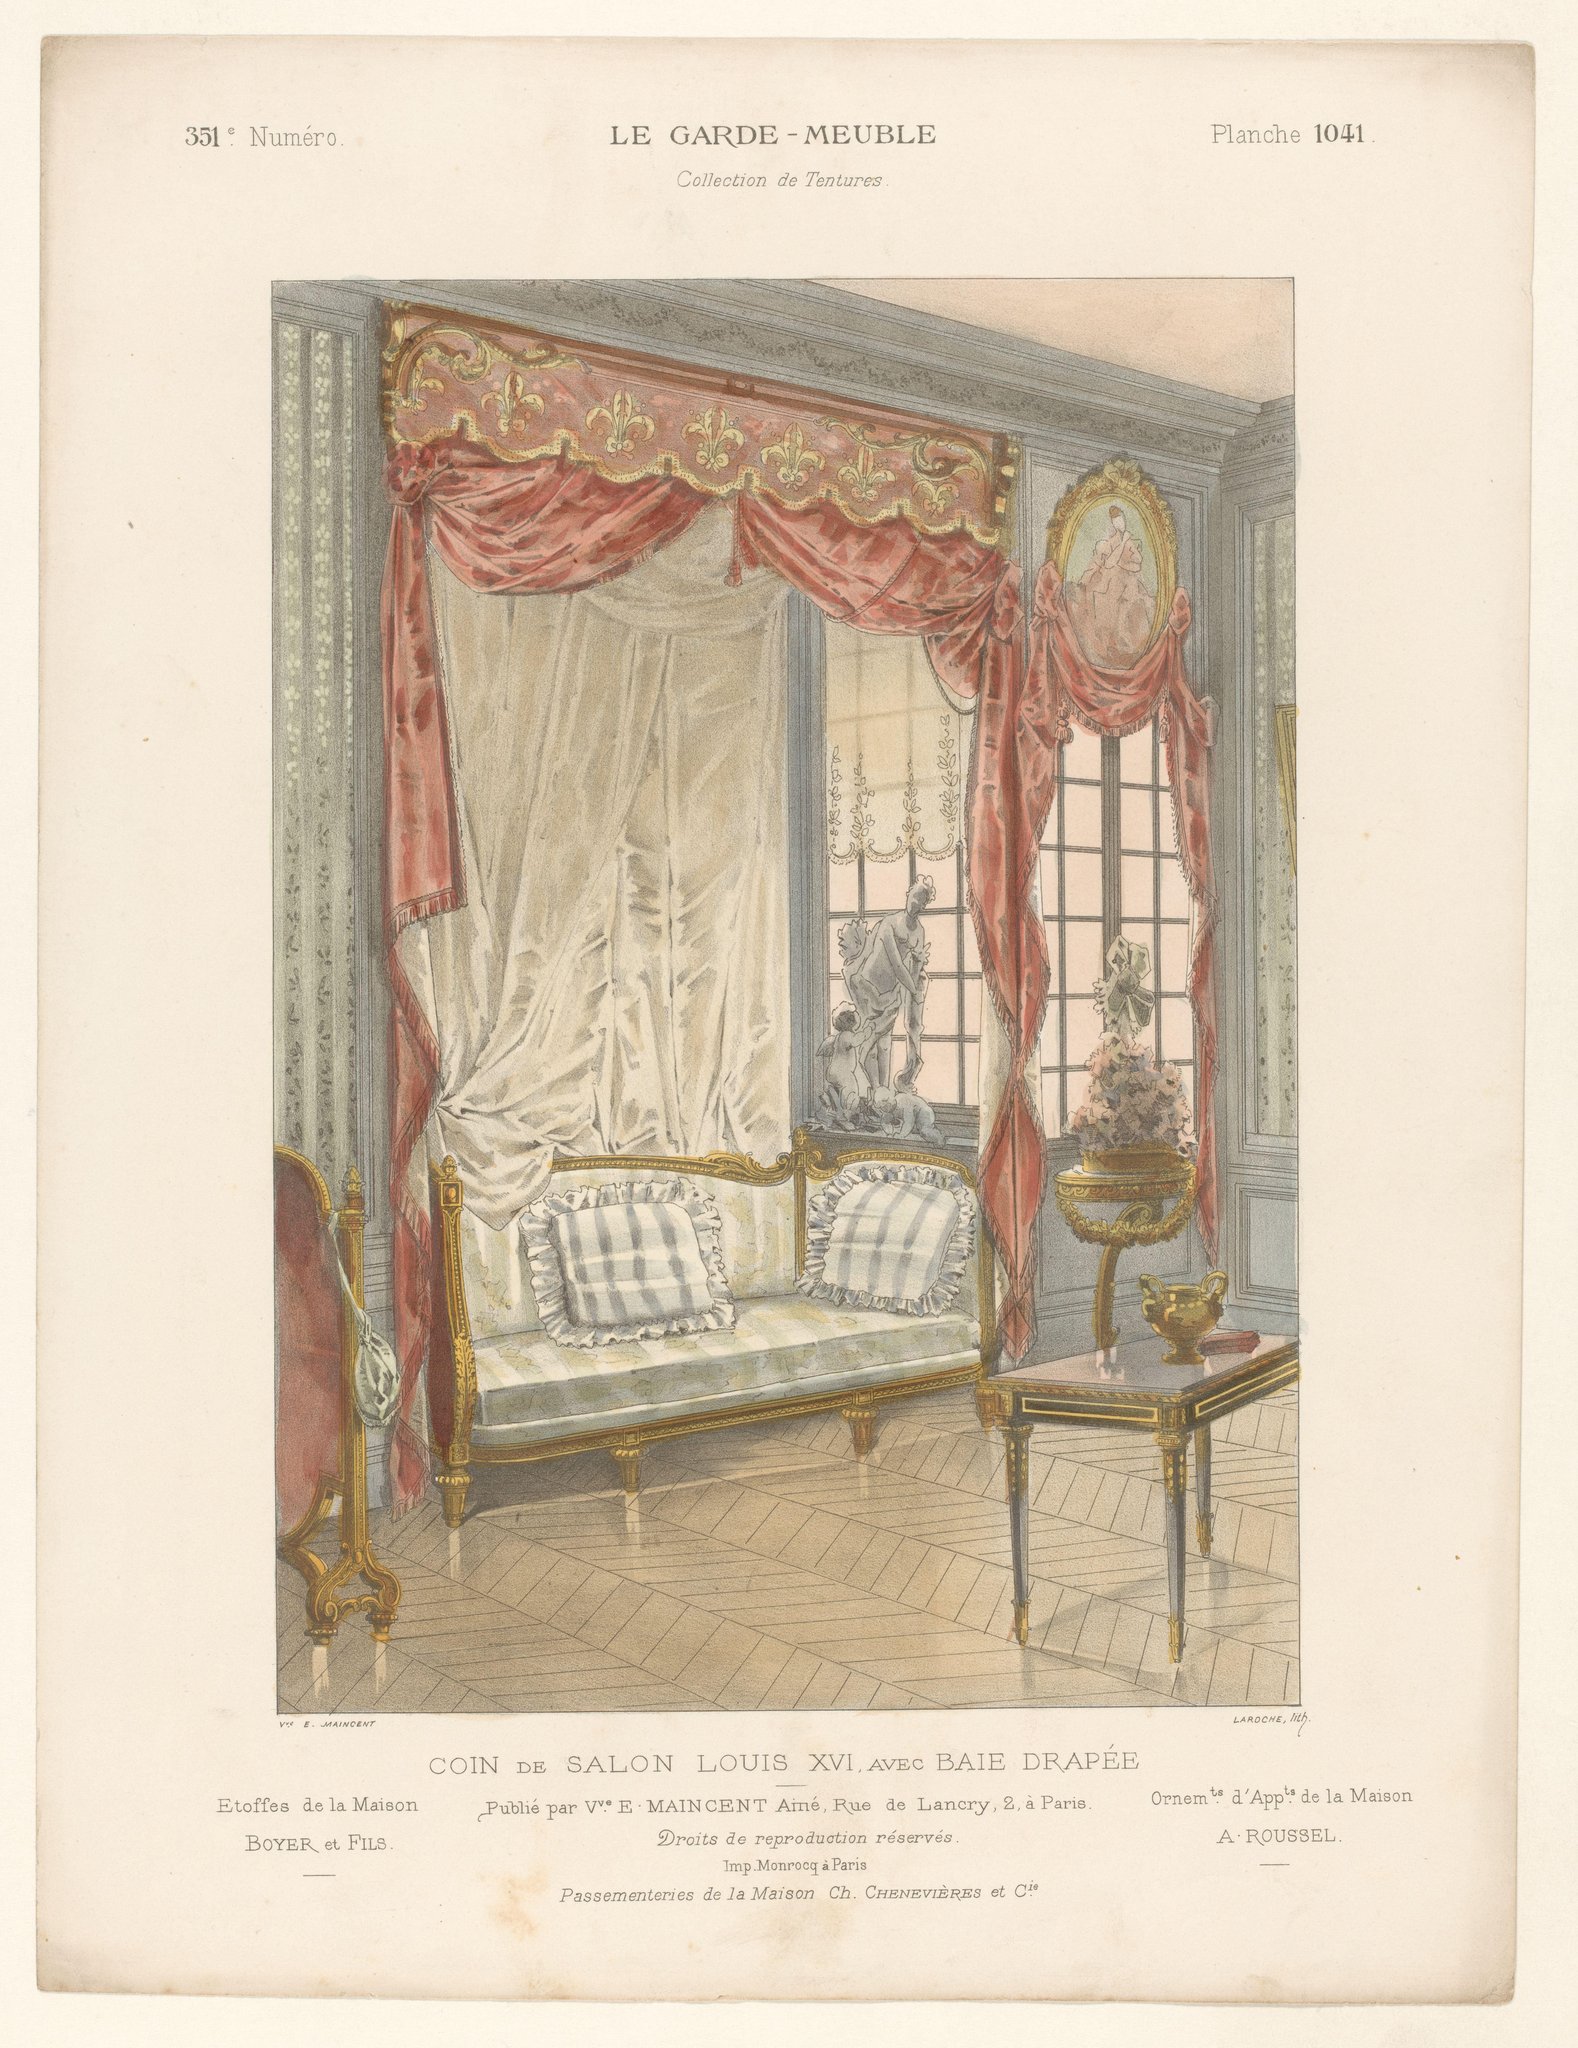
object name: print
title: Le Garde-Meuble / Collection de Tentures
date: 1895-1910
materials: paper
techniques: hand coloring, lithograph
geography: paris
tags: drawing-room, 'salon', window, hangings and drapery, couch, sofa, settee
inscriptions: : ‘Droits de reproduction réservés.’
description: Zithoek met vensters en baldakijn met gedrapeerde gordijnen in de Lodewijk XVI-stijl. Prent uit 351e Livraison.